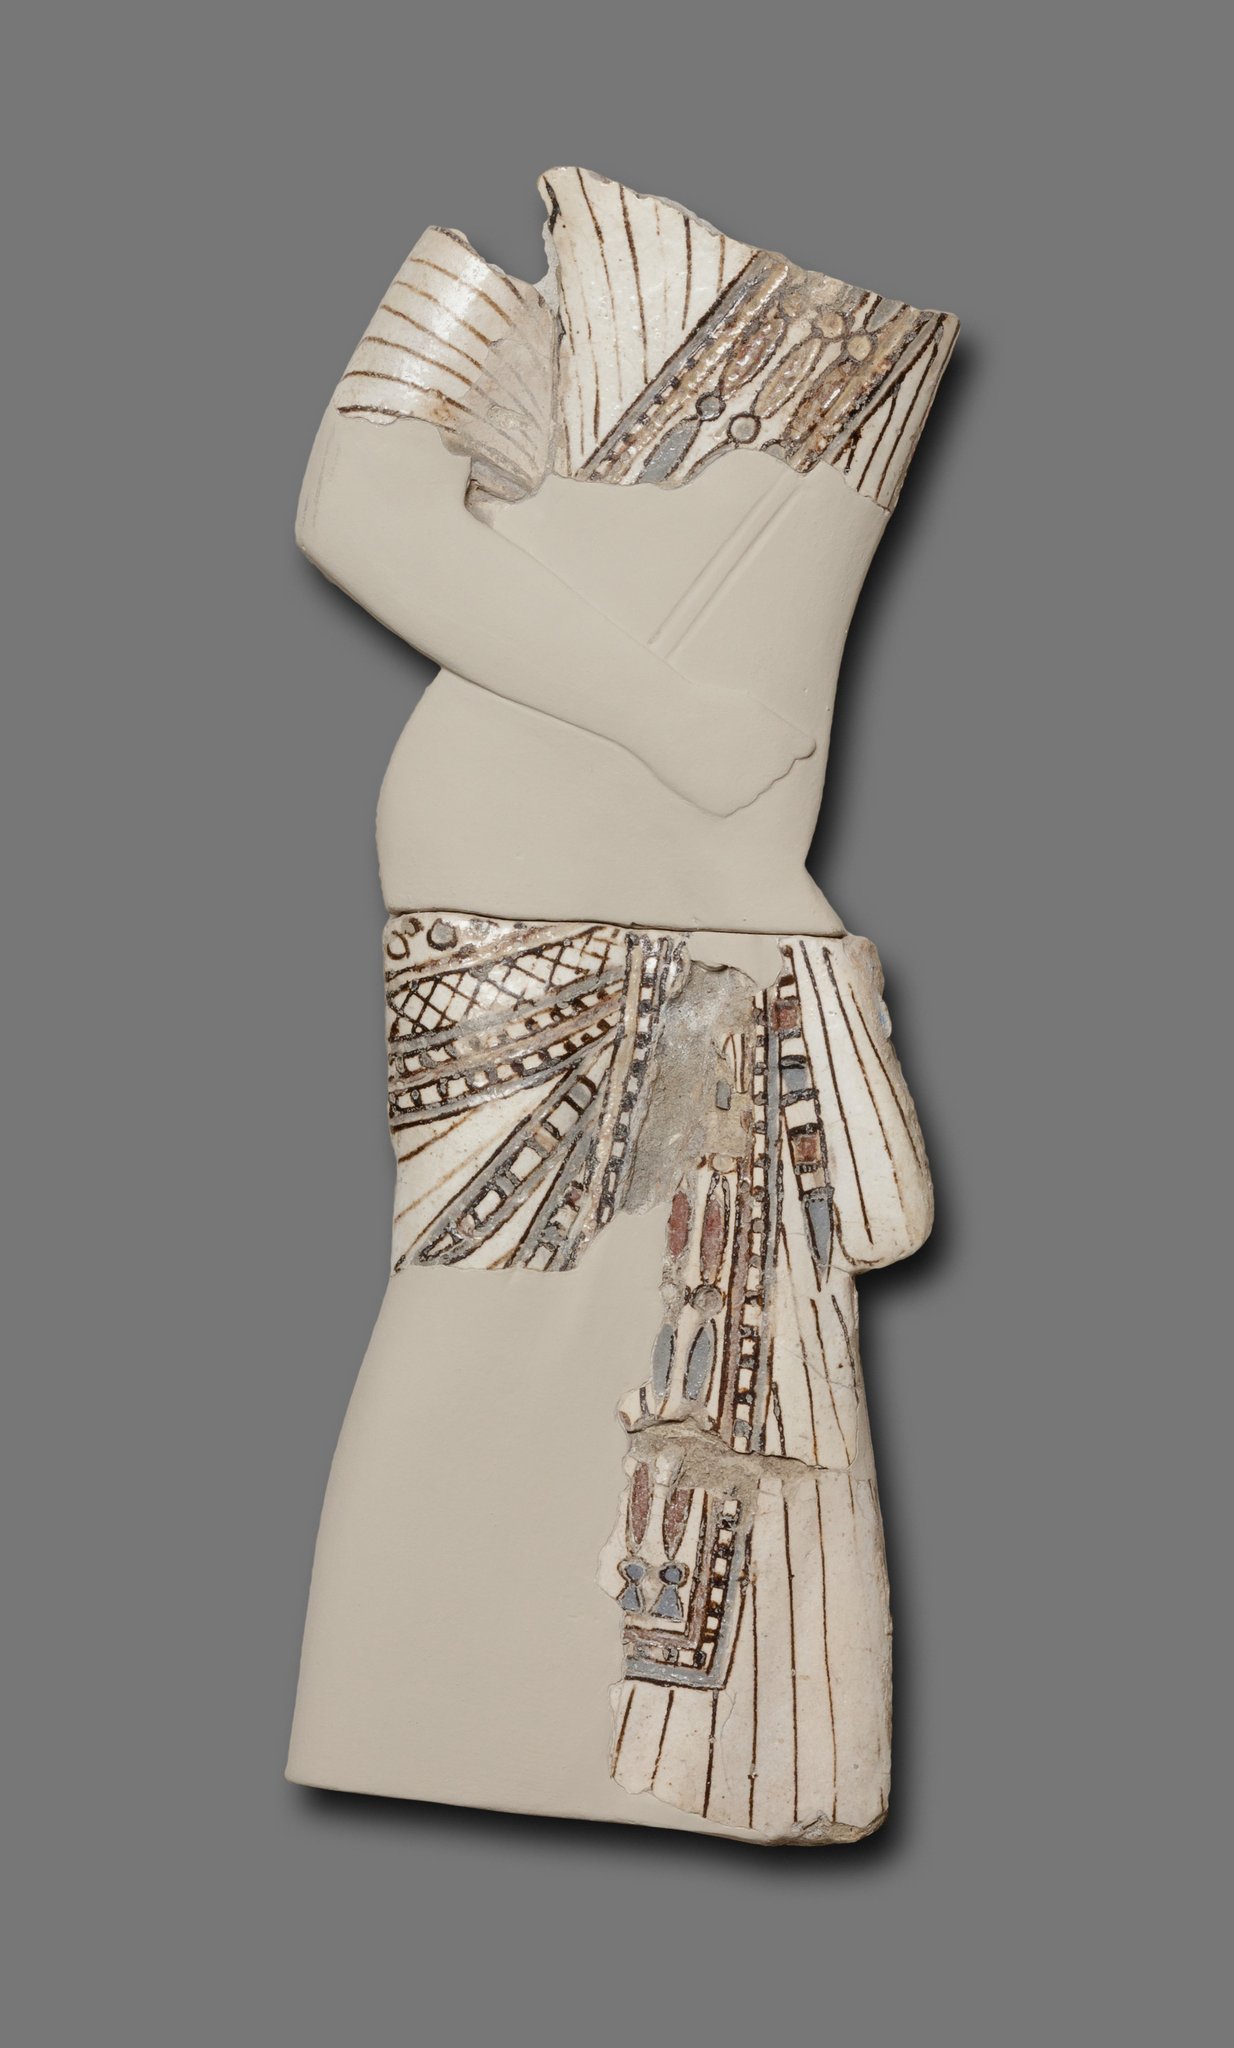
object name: tile inlay, palace of ramesses ii, foreigner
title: Tile Inlay Depicting a Torso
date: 1279-1213 BCE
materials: faience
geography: egypt